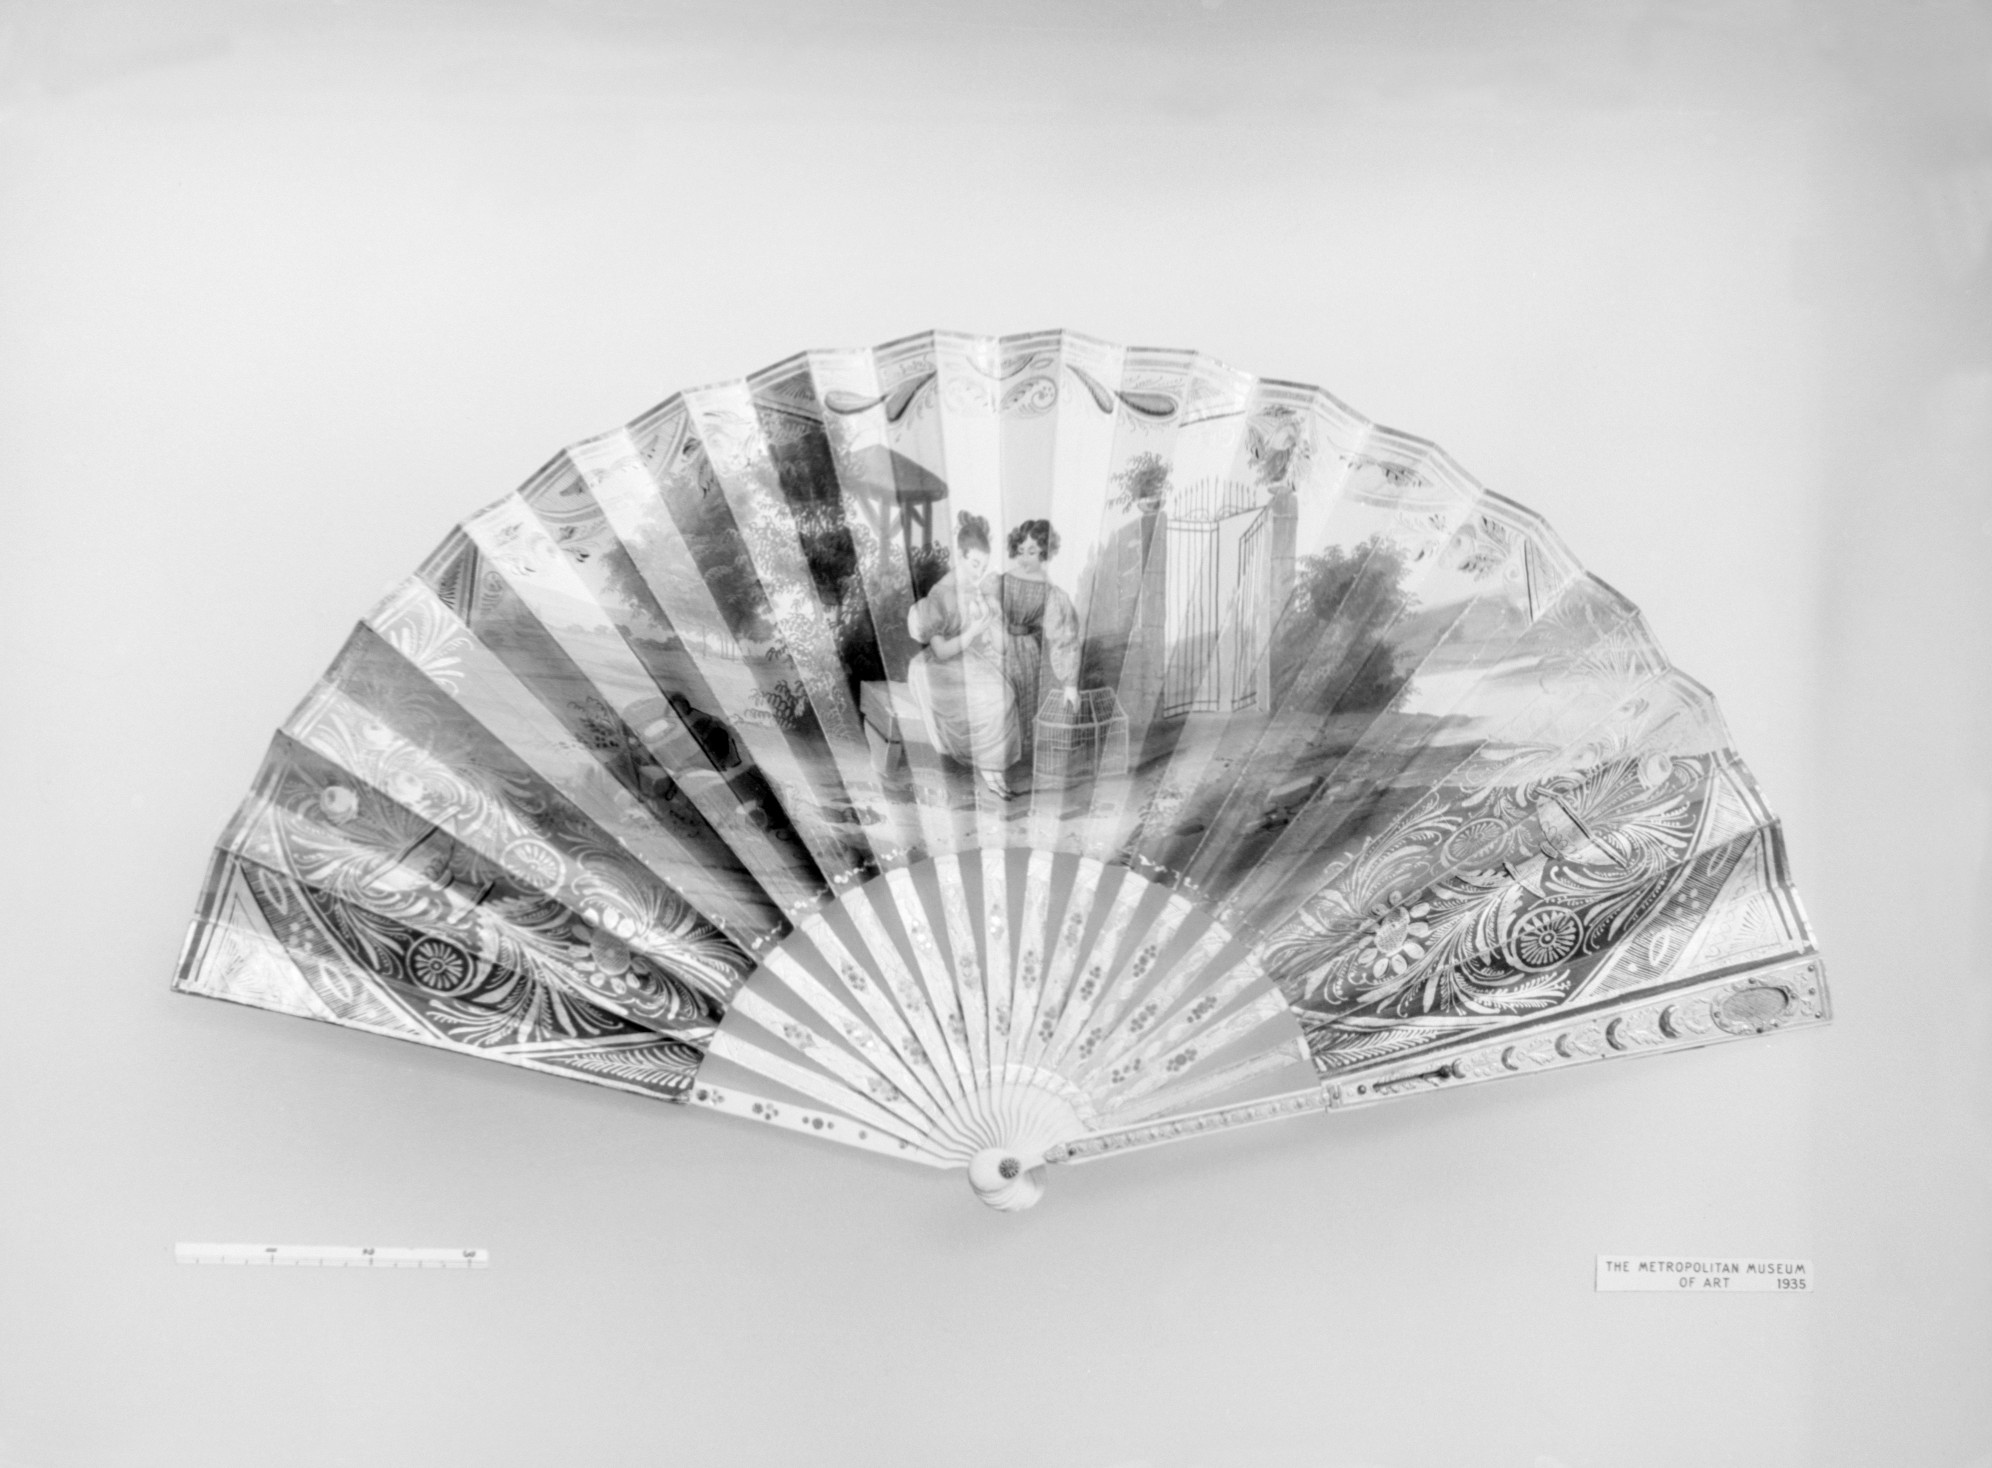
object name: fan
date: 1801-1850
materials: gilt, ivory, mother of pearl, paper, shell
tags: birds,women